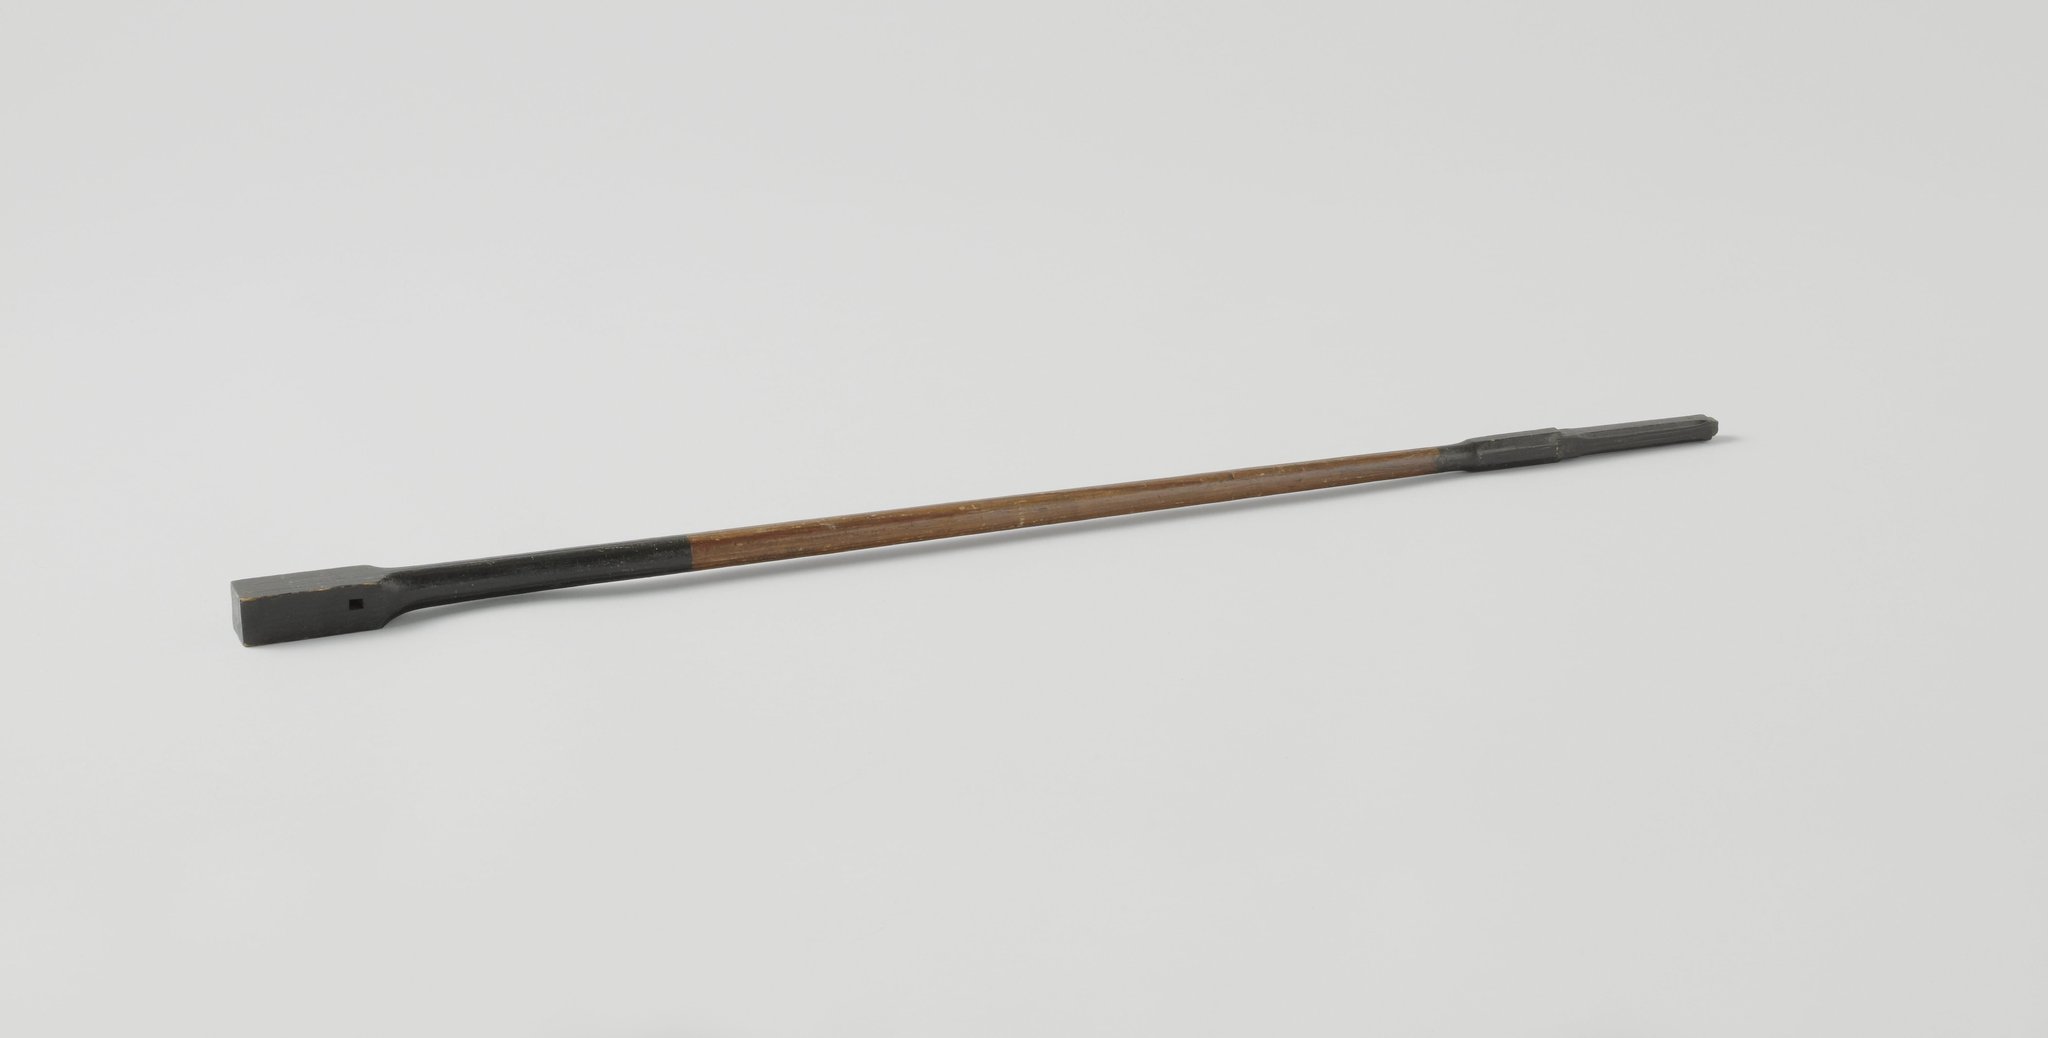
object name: demonstration model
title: Model of a Main Topmast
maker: Anonymous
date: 1780-1840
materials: paint, wood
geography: netherlands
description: Model van de grote steng behorend bij NG-MC-126. De steng is rond en uit een stuk gemaakt, met een dikke vierkante hiel met slothoutgat, een achtkantige hommer en vierkante top.